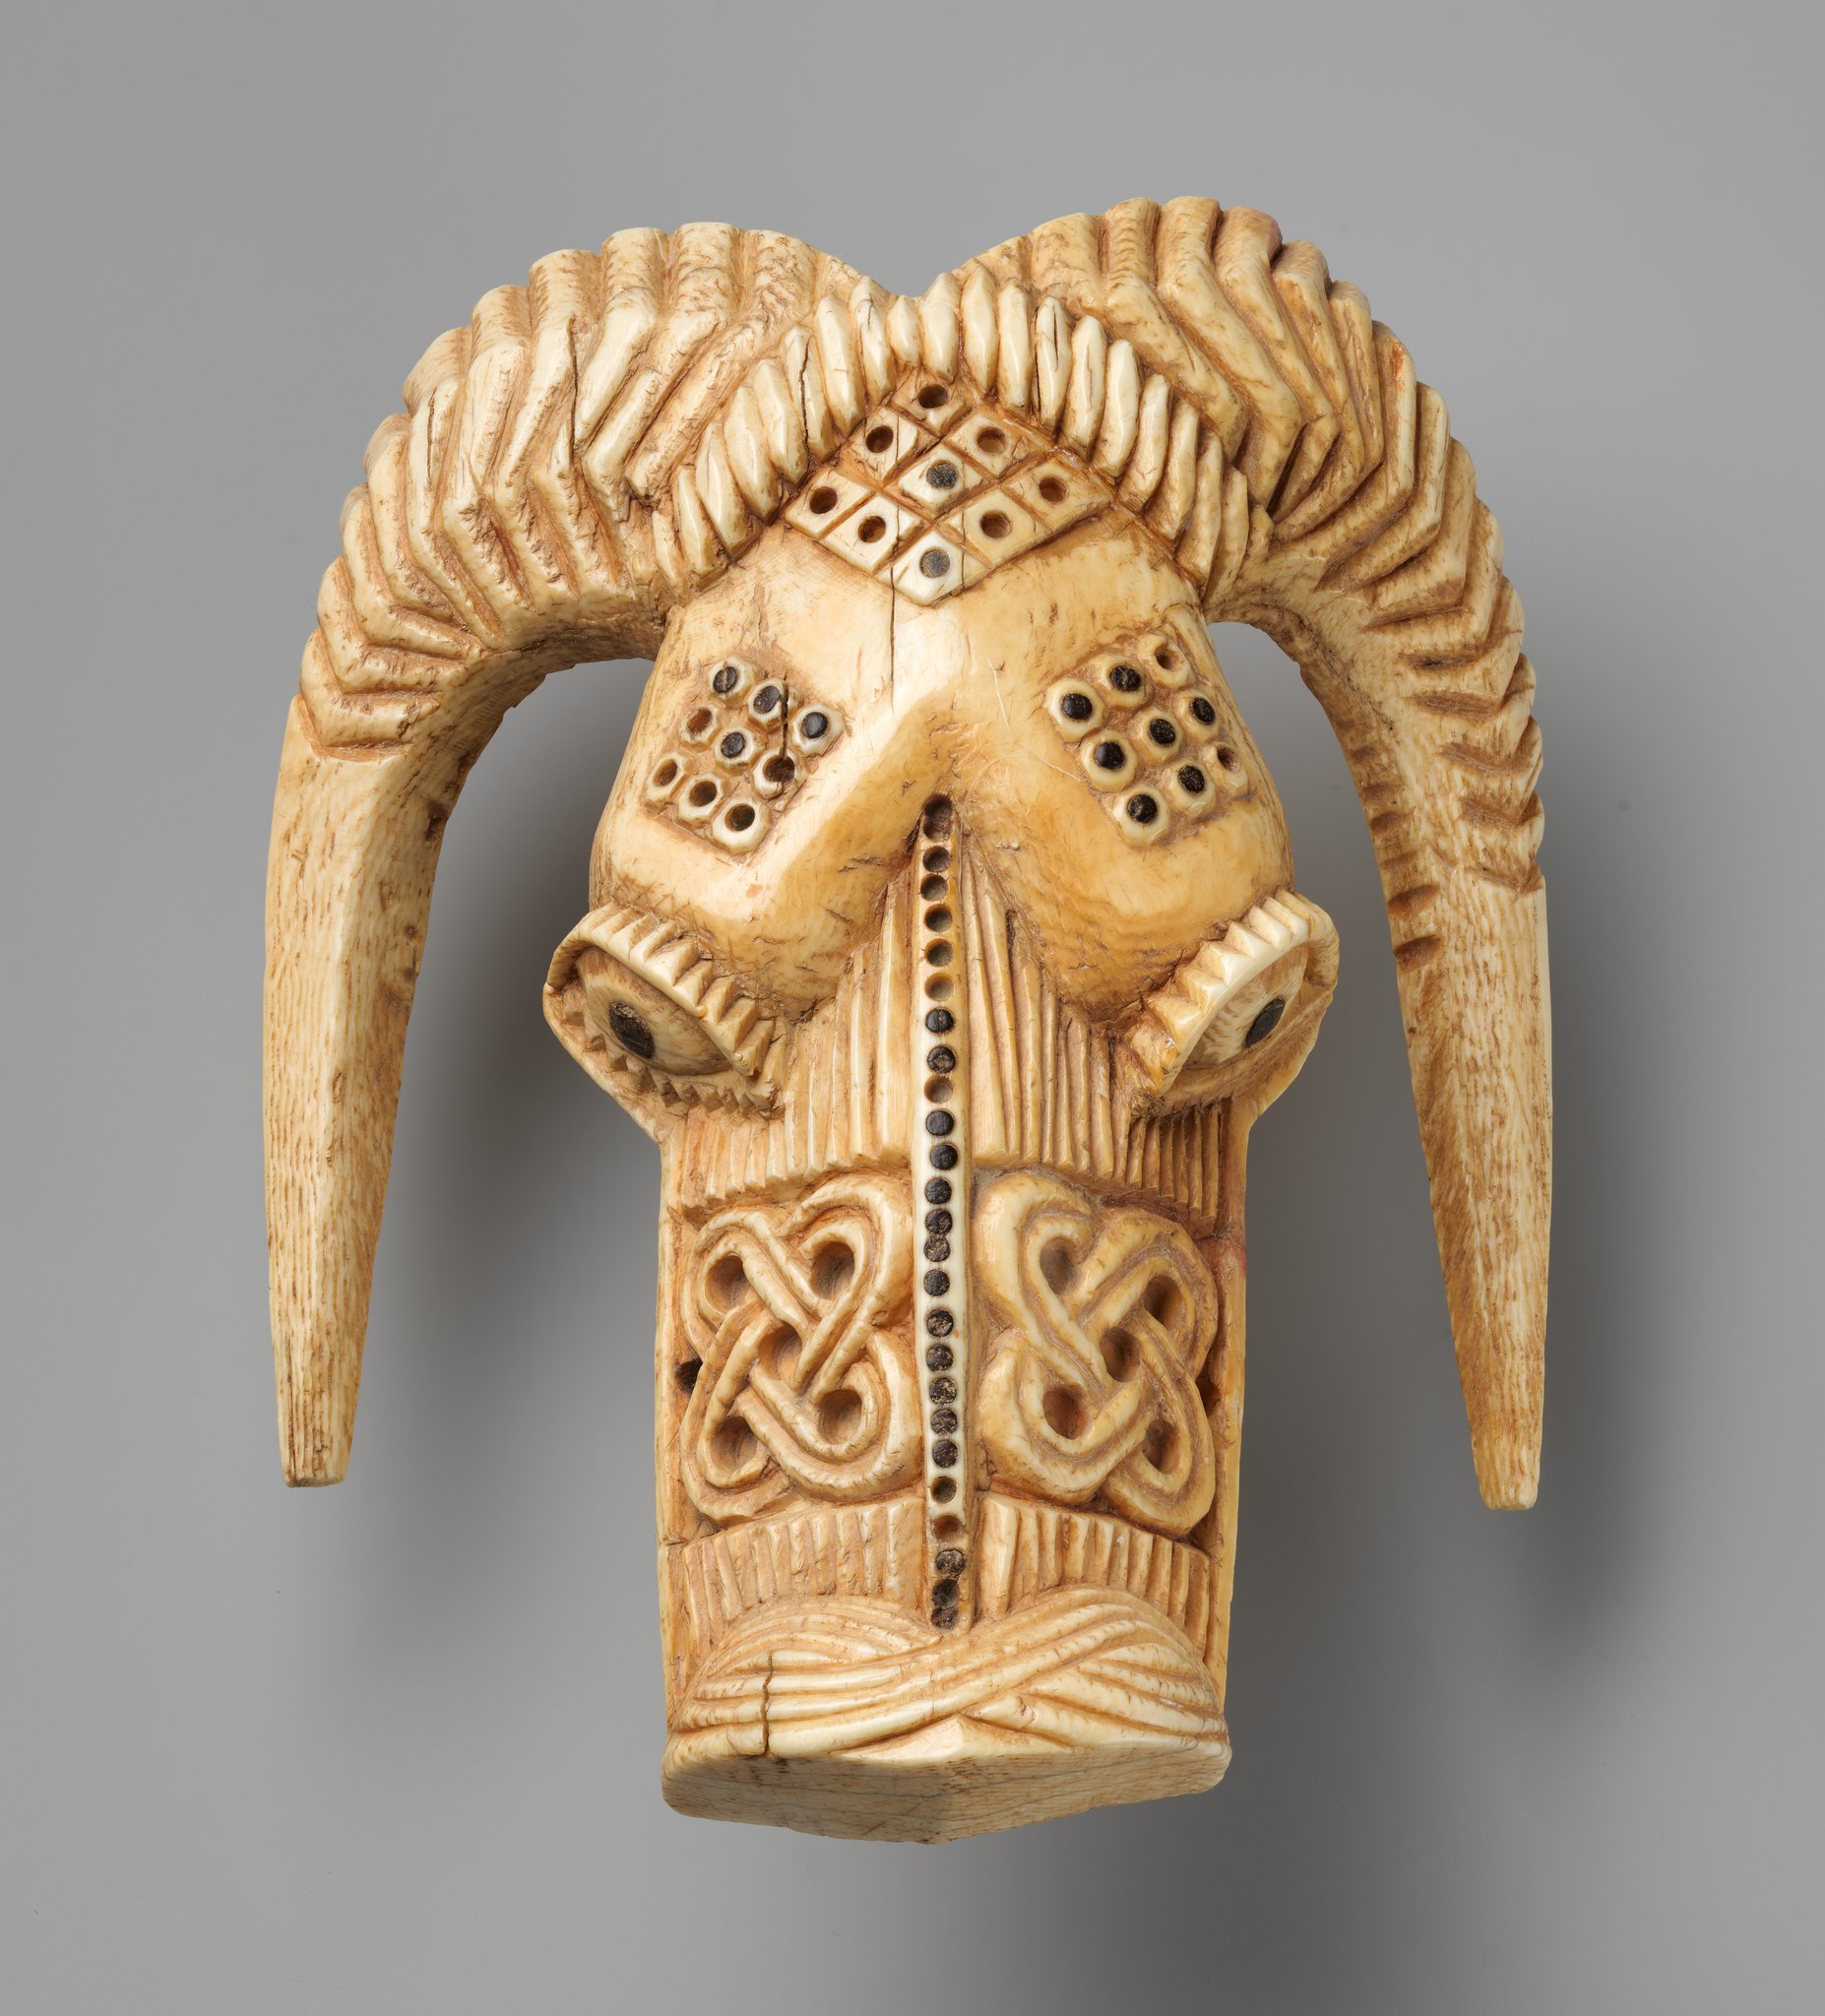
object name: costume element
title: Orufanran Costume Attachment: Ram Head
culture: yoruba peoples, owo group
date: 1601-1900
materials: plant material, ivory, wood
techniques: inlay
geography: nigeria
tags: rams